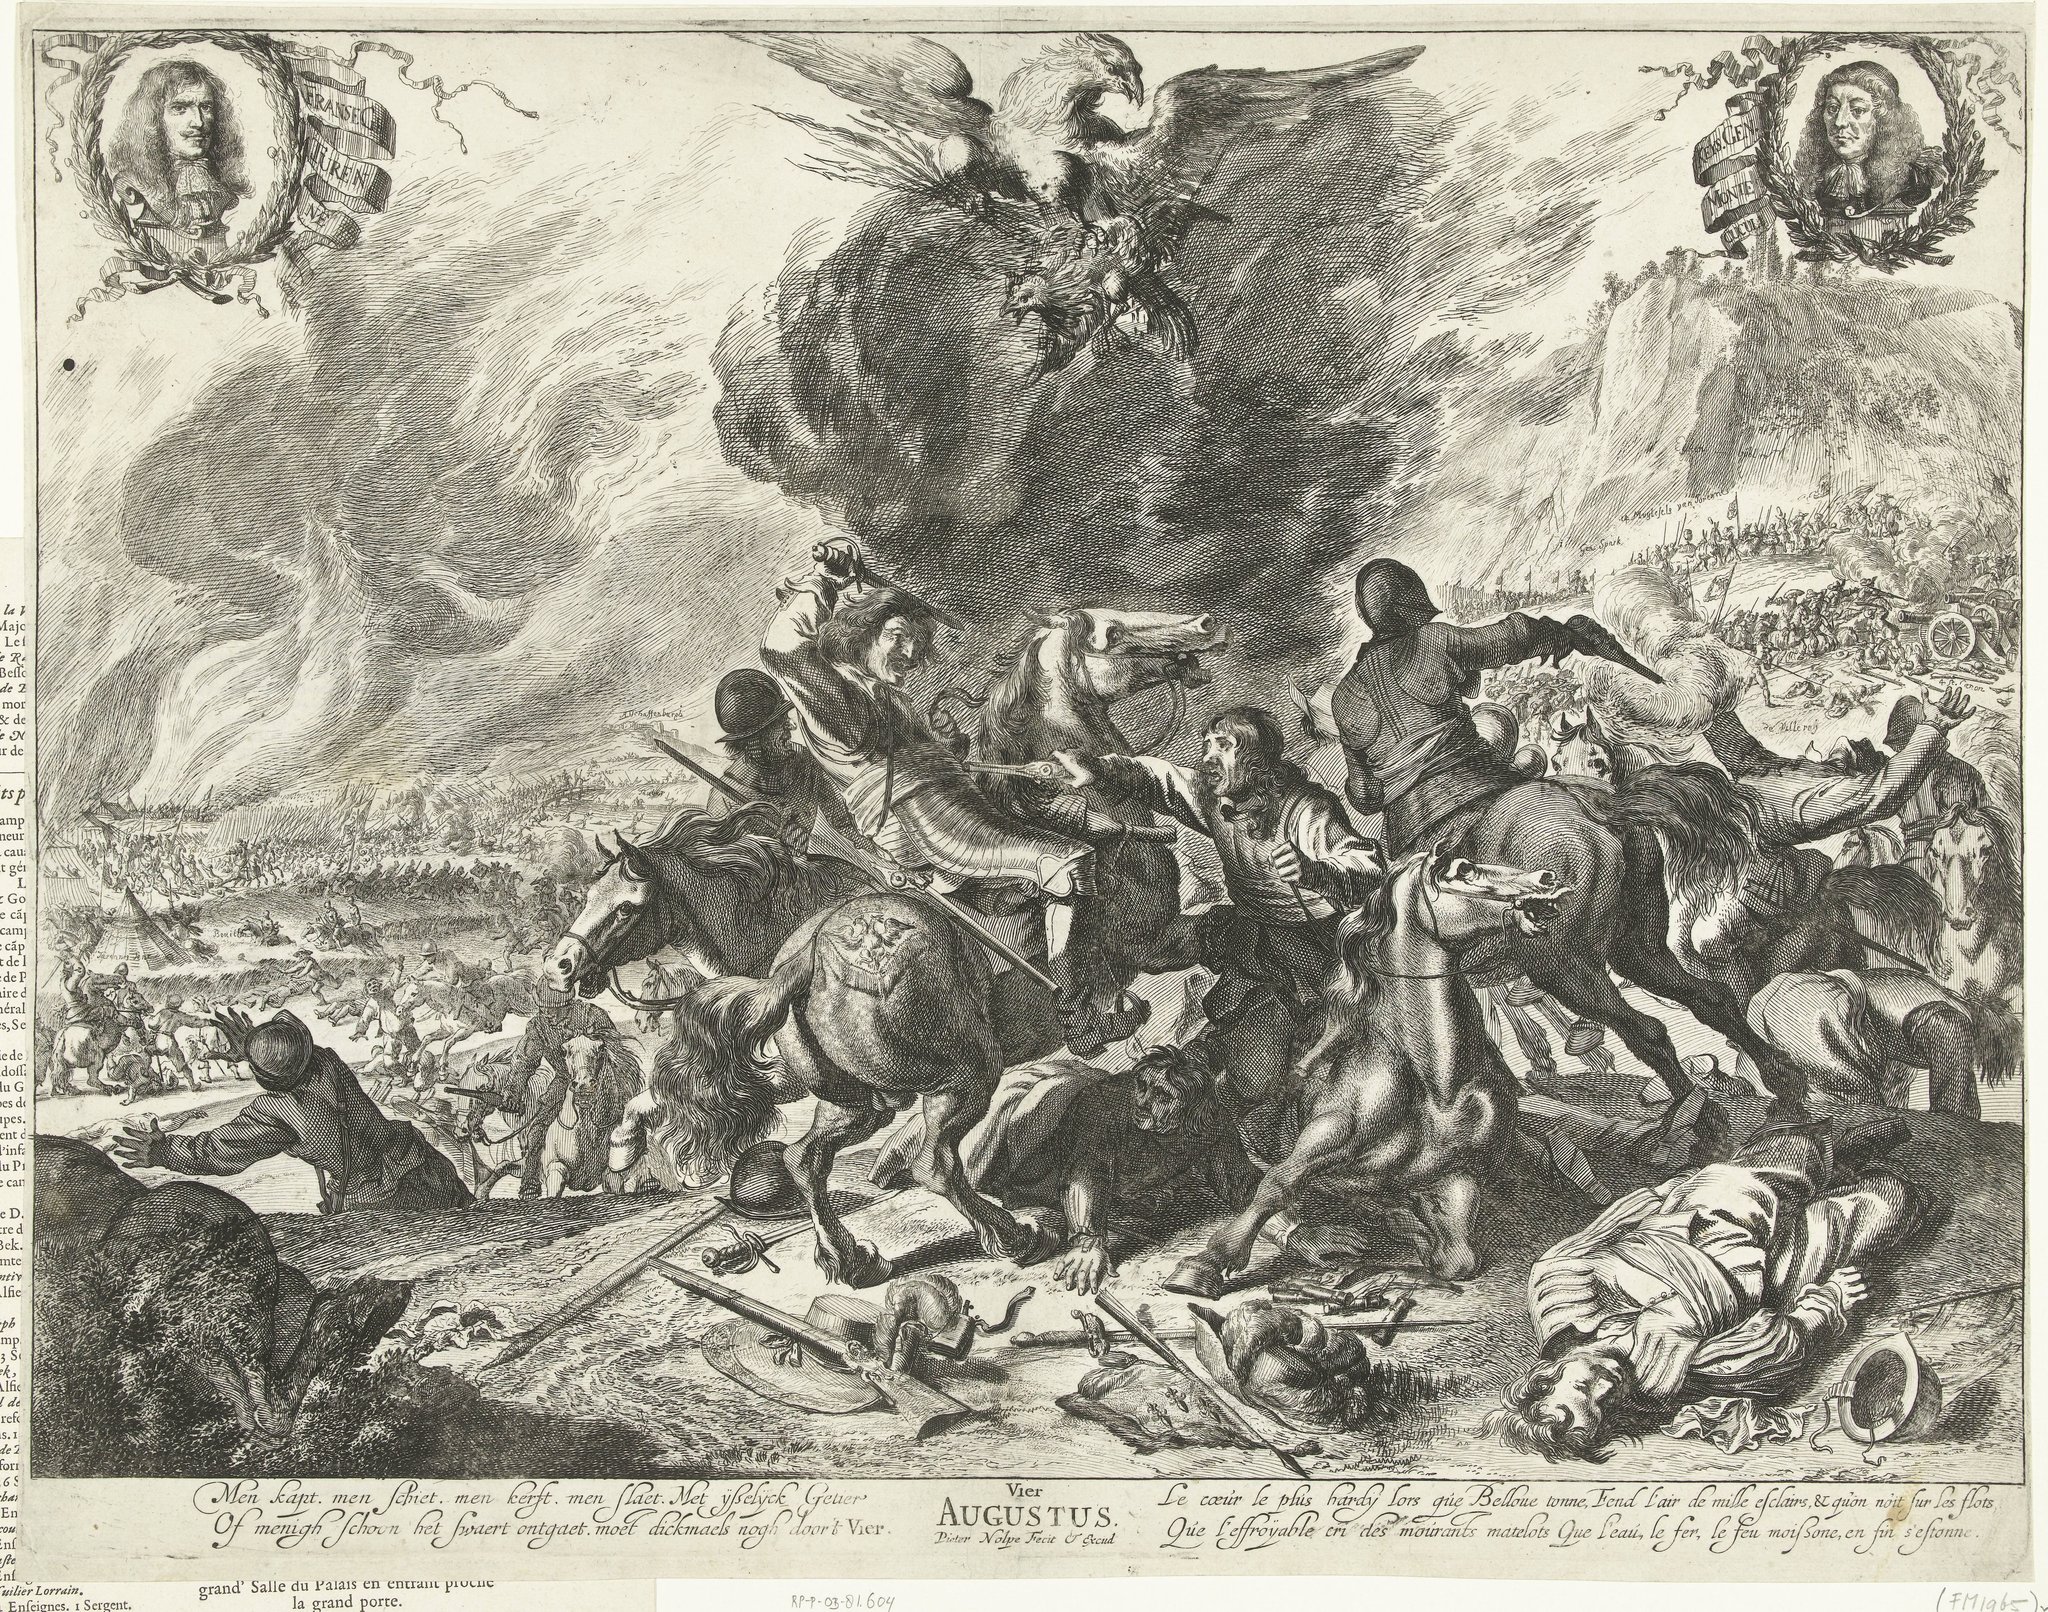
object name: print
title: Gevecht bij Aschaffenburg, 1674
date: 1649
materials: paper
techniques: etching, letterpress printing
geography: northern netherlands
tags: battle (+ land forces)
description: Gevecht bij Aschaffenburg op 4 augustus 1674 tussen het Franse leger onder Turenne en het Oostenrijkse leger onder Montecuccoli. Op de voorgrond een ruitergevecht, daarachter de veldslag met hoge rookwolken, rechts een berg, in de verte Aschaffenburg. Bovenaan portretten van Turenne en Montecuccoli, in het midden grijpt de Oostenrijkse adelaar de Franse haan in de klauwen. In het onderschrift 2 regels in het Nederlands en 2 regels in het Frans, daartussen: Vier Augustus.